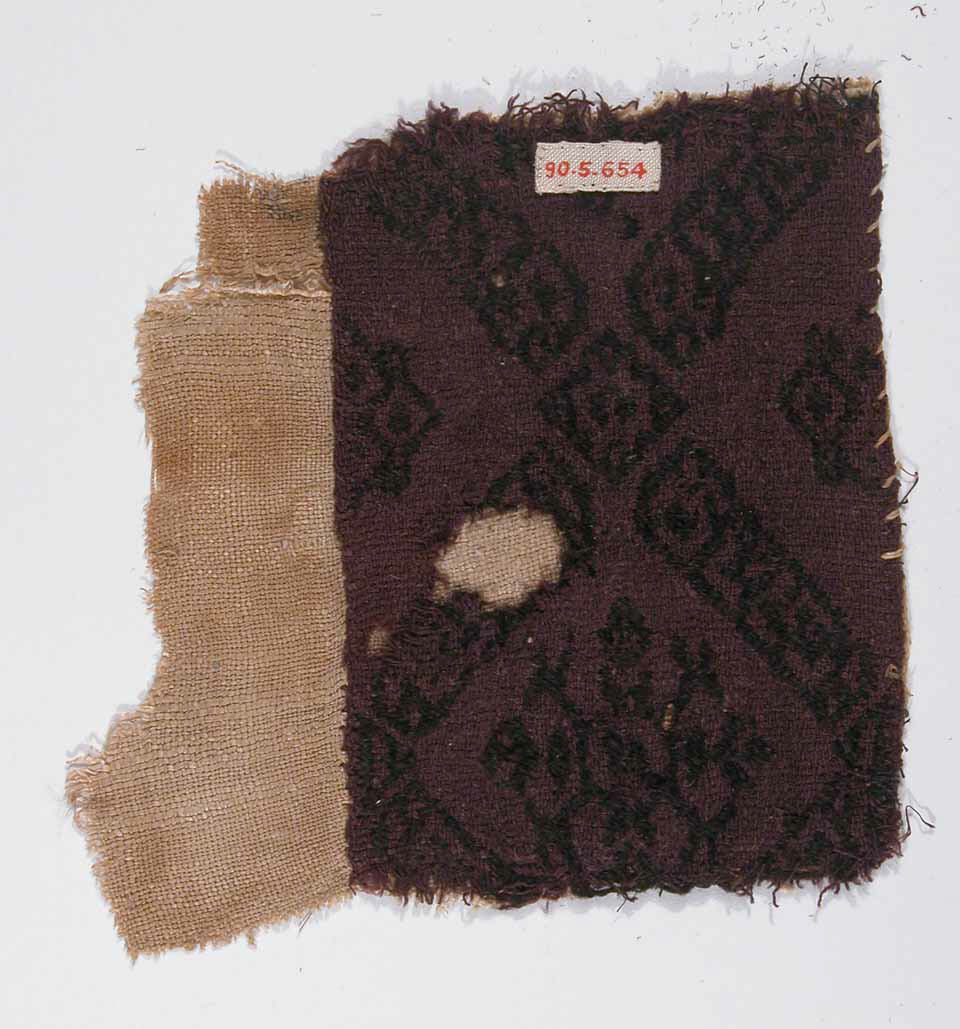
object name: textile fragment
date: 401-600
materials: wool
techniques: brocade, weave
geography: egypt